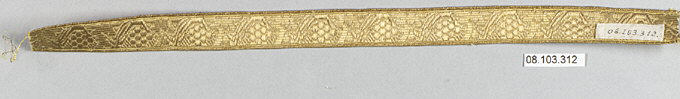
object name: galloon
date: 1601-1800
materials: metal thread